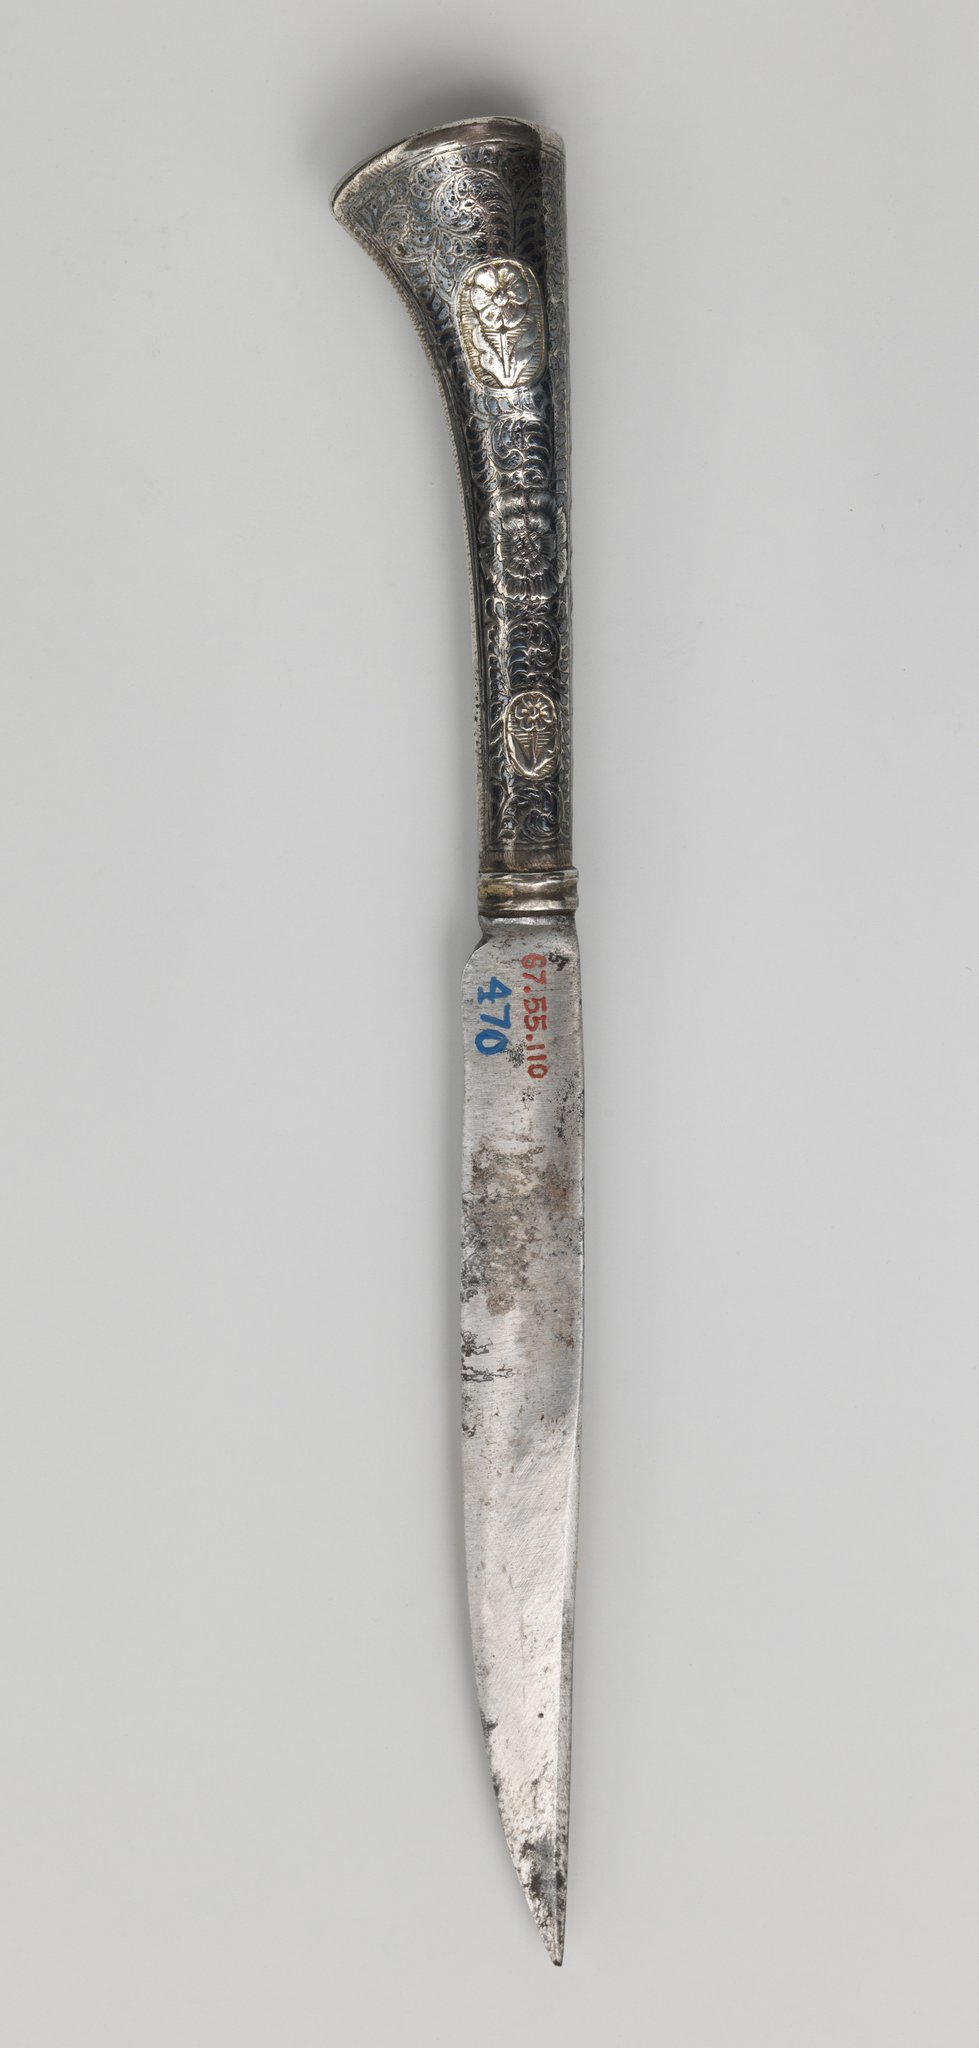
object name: knife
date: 1801-1900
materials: silver, steel